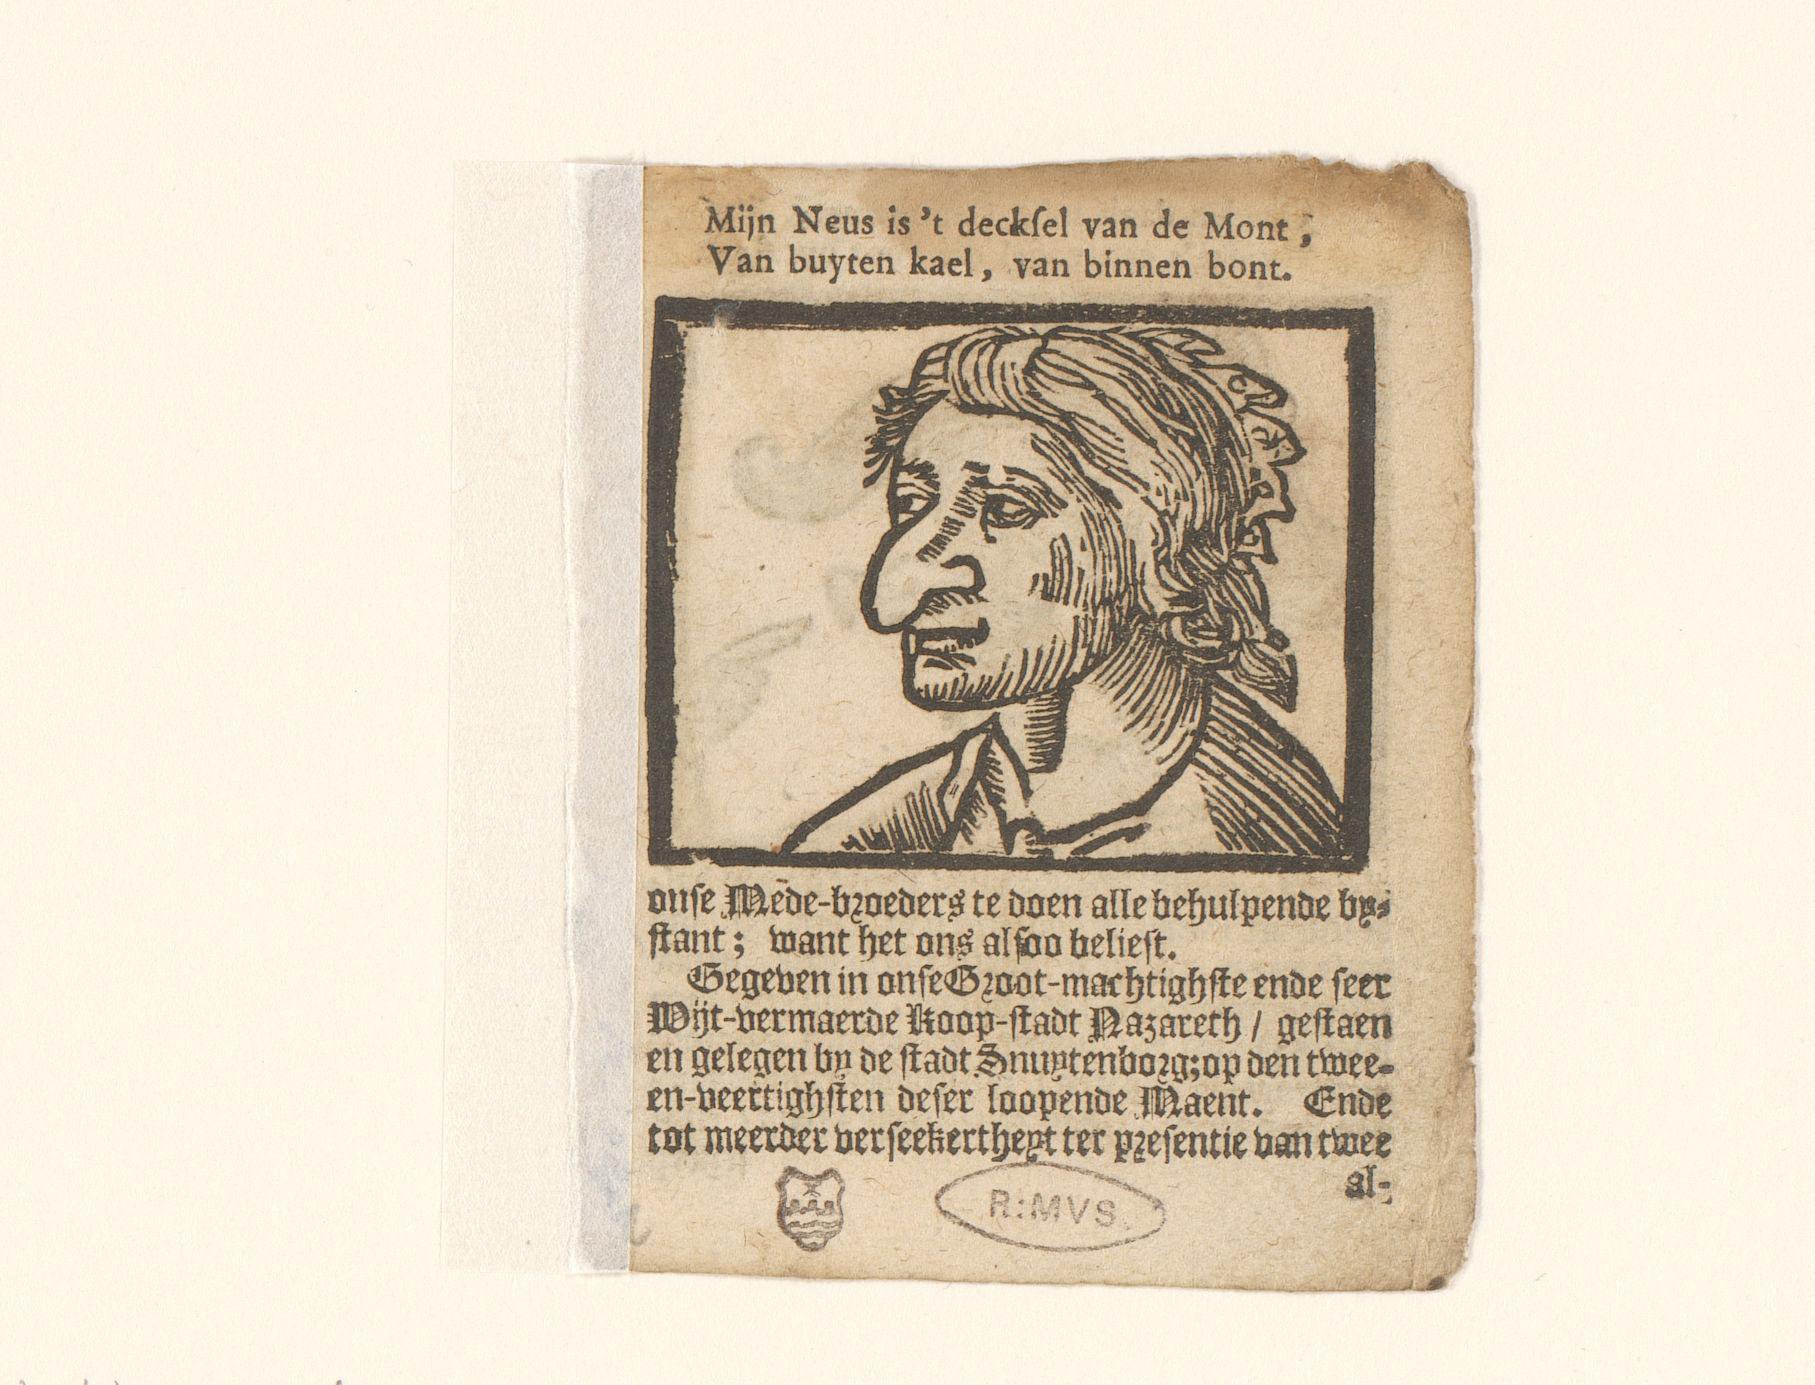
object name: print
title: Vrouw met grote kromme neus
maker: Anonymous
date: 1715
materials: paper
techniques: letterpress printing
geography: northern netherlands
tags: caricatures (human types), parts of the face: nose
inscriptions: collector's mark: Lugt 2760, collector's mark: Lugt 2228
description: Prent waarschijnlijk uit: Placcaet ende Ordonnantie van het Neuse-Geldt ofte Gilt van de Neuzen. Spit, Schit, Hagendevelt van Neuzen. Groningen: s.n., 1715. De prent is waarschijnlijk gemaakt naar een zestiende- of zeventiende-eeuws voorbeeld.